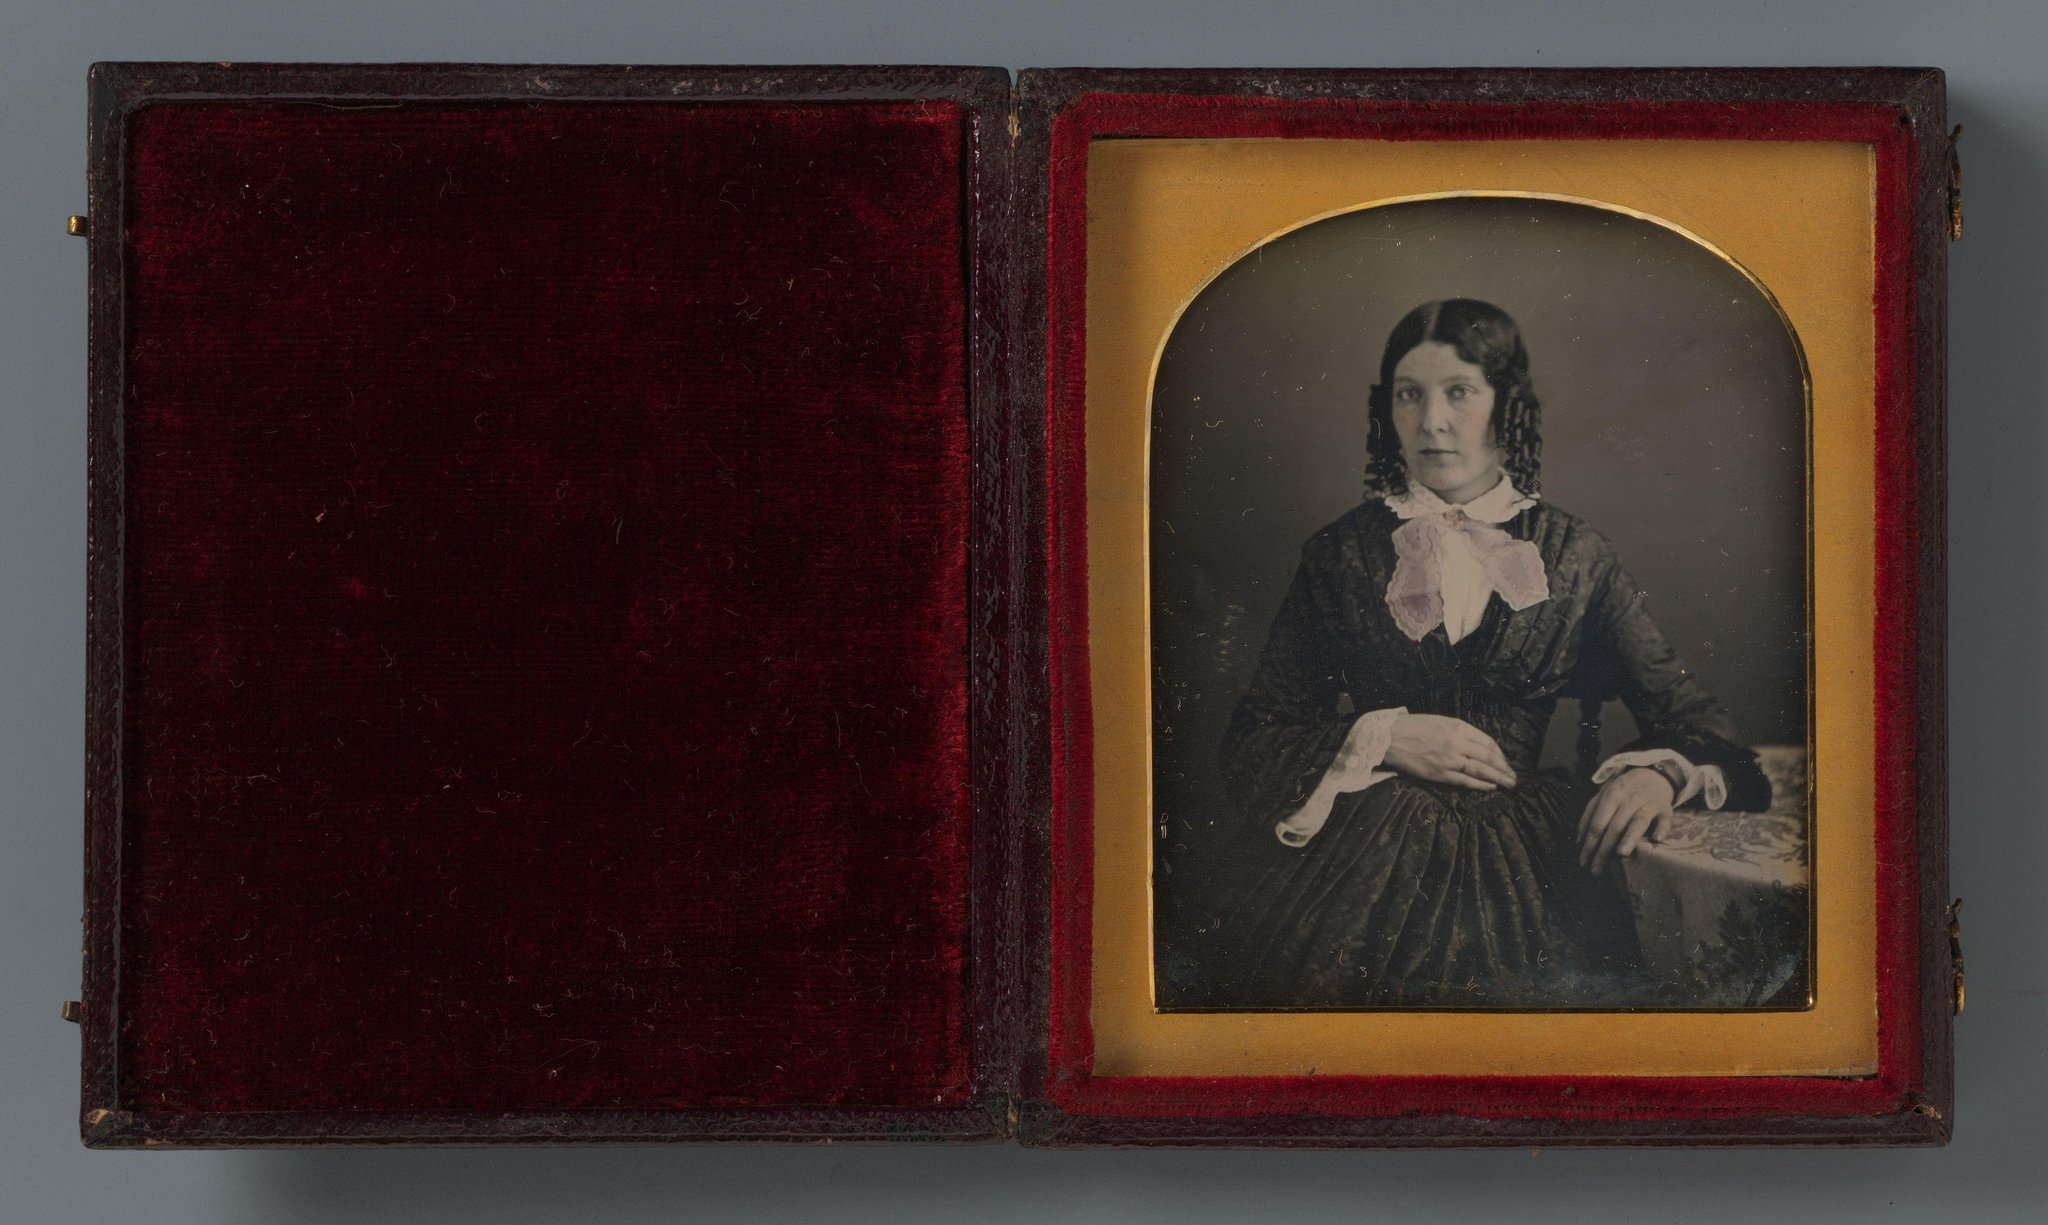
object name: photograph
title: Portret van een onbekende vrouw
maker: Anonymous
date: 1840-1860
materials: copper, glass, leather, velvet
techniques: daguerreotype, hand coloring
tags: adult woman, historical persons